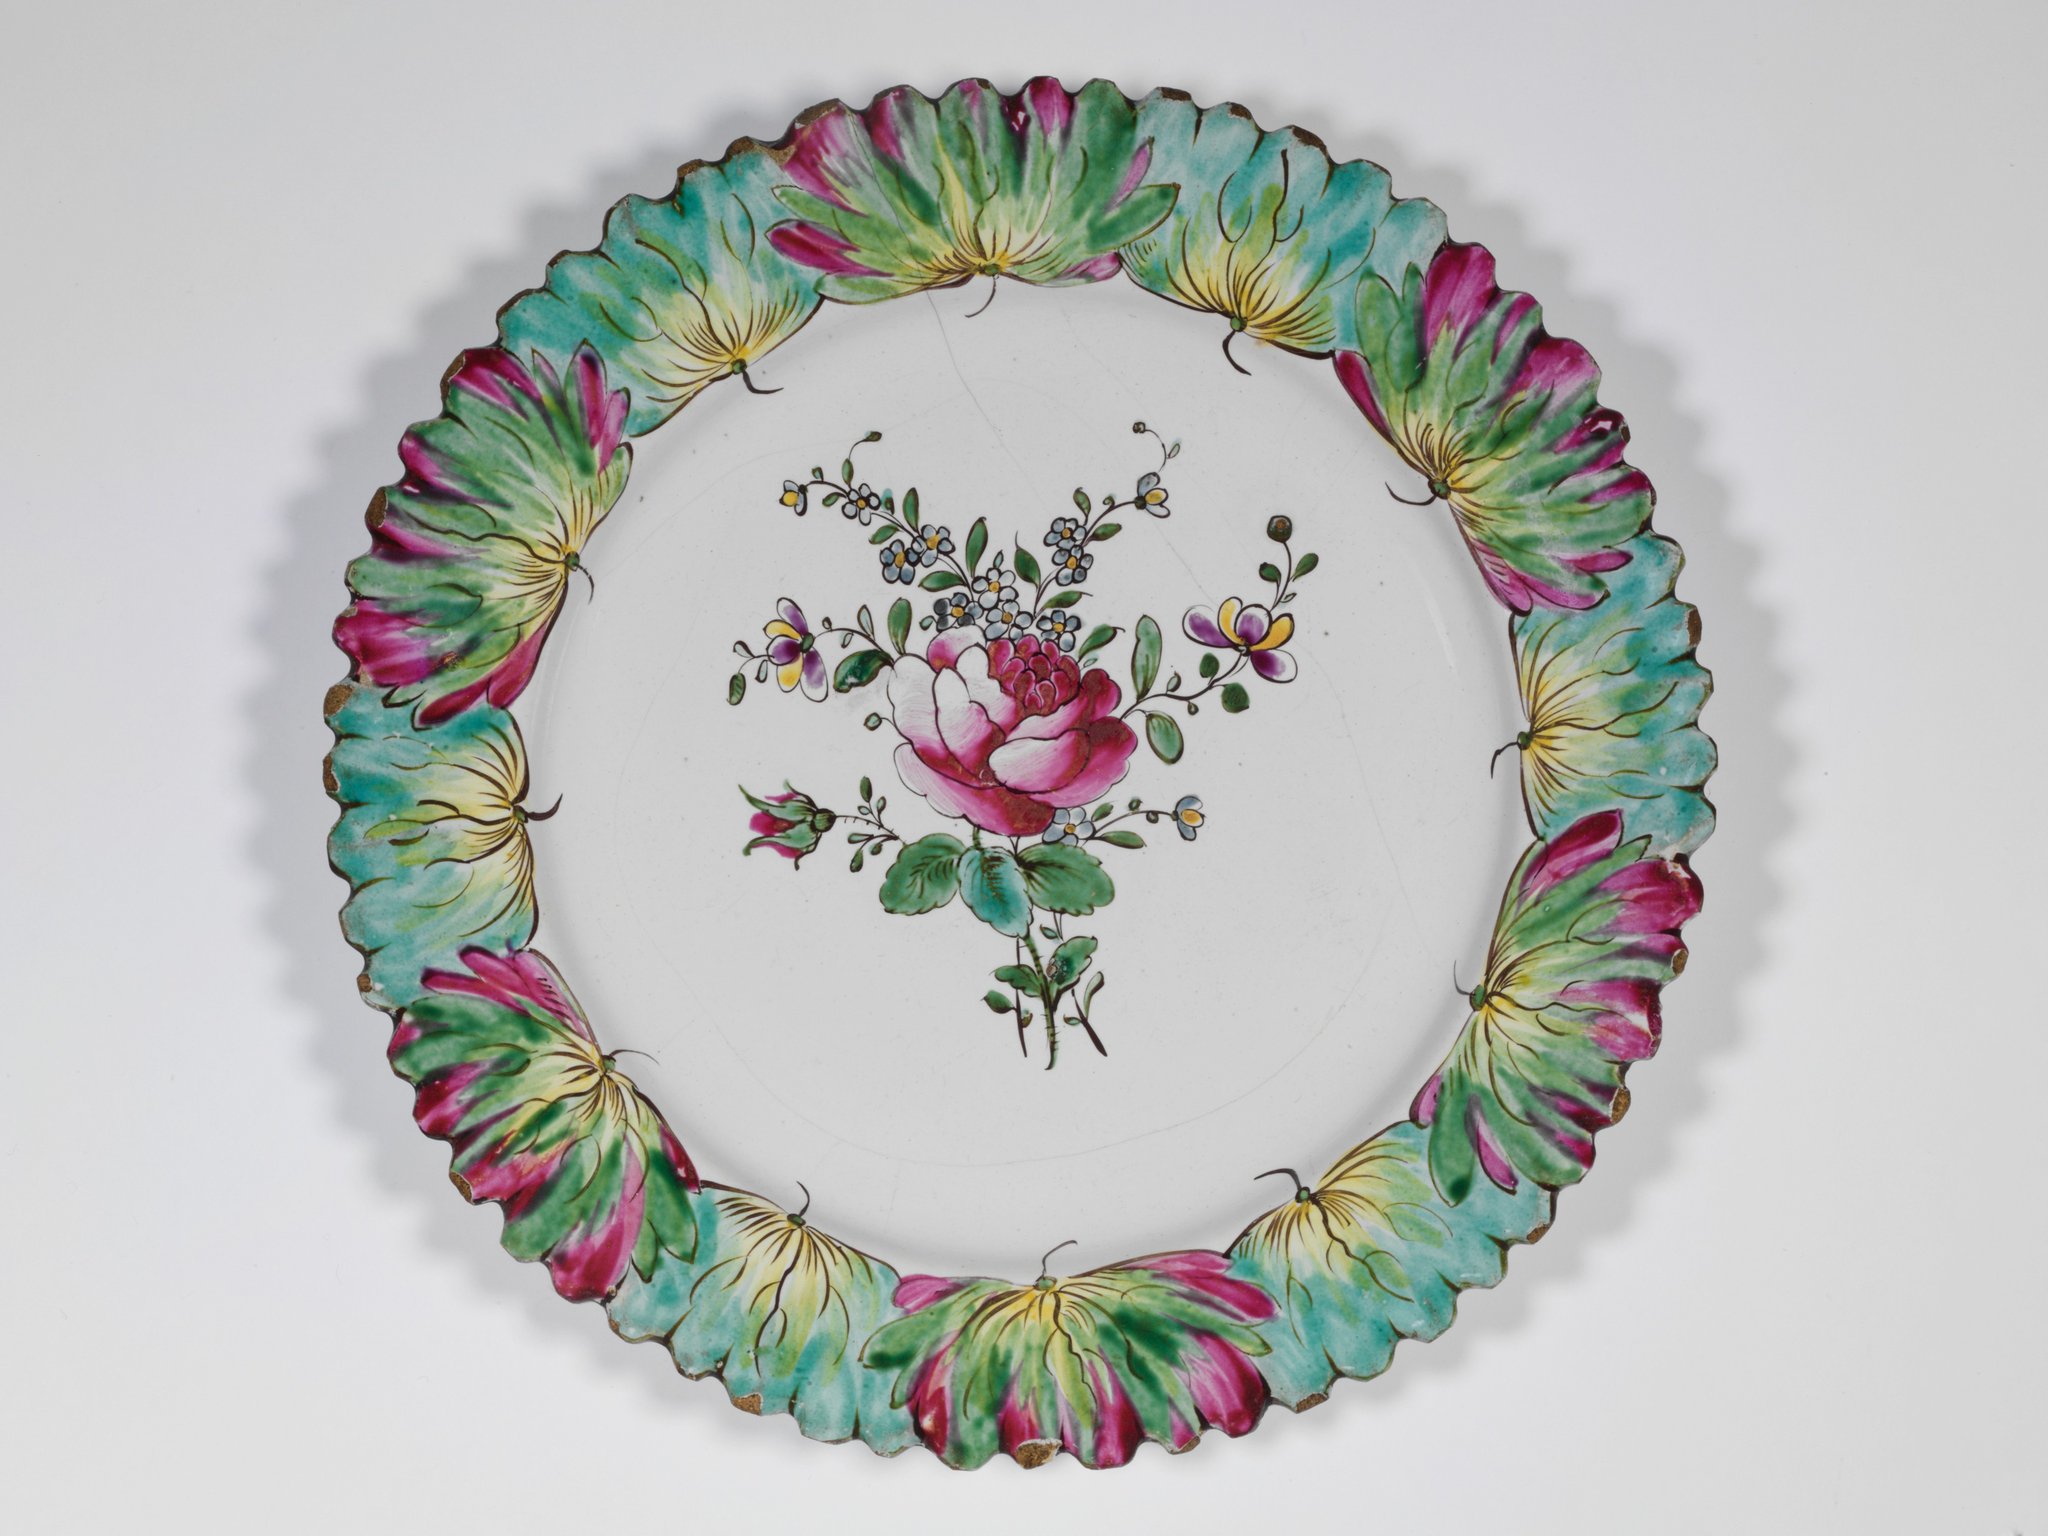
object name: plate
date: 1769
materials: faience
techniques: glazing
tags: roses